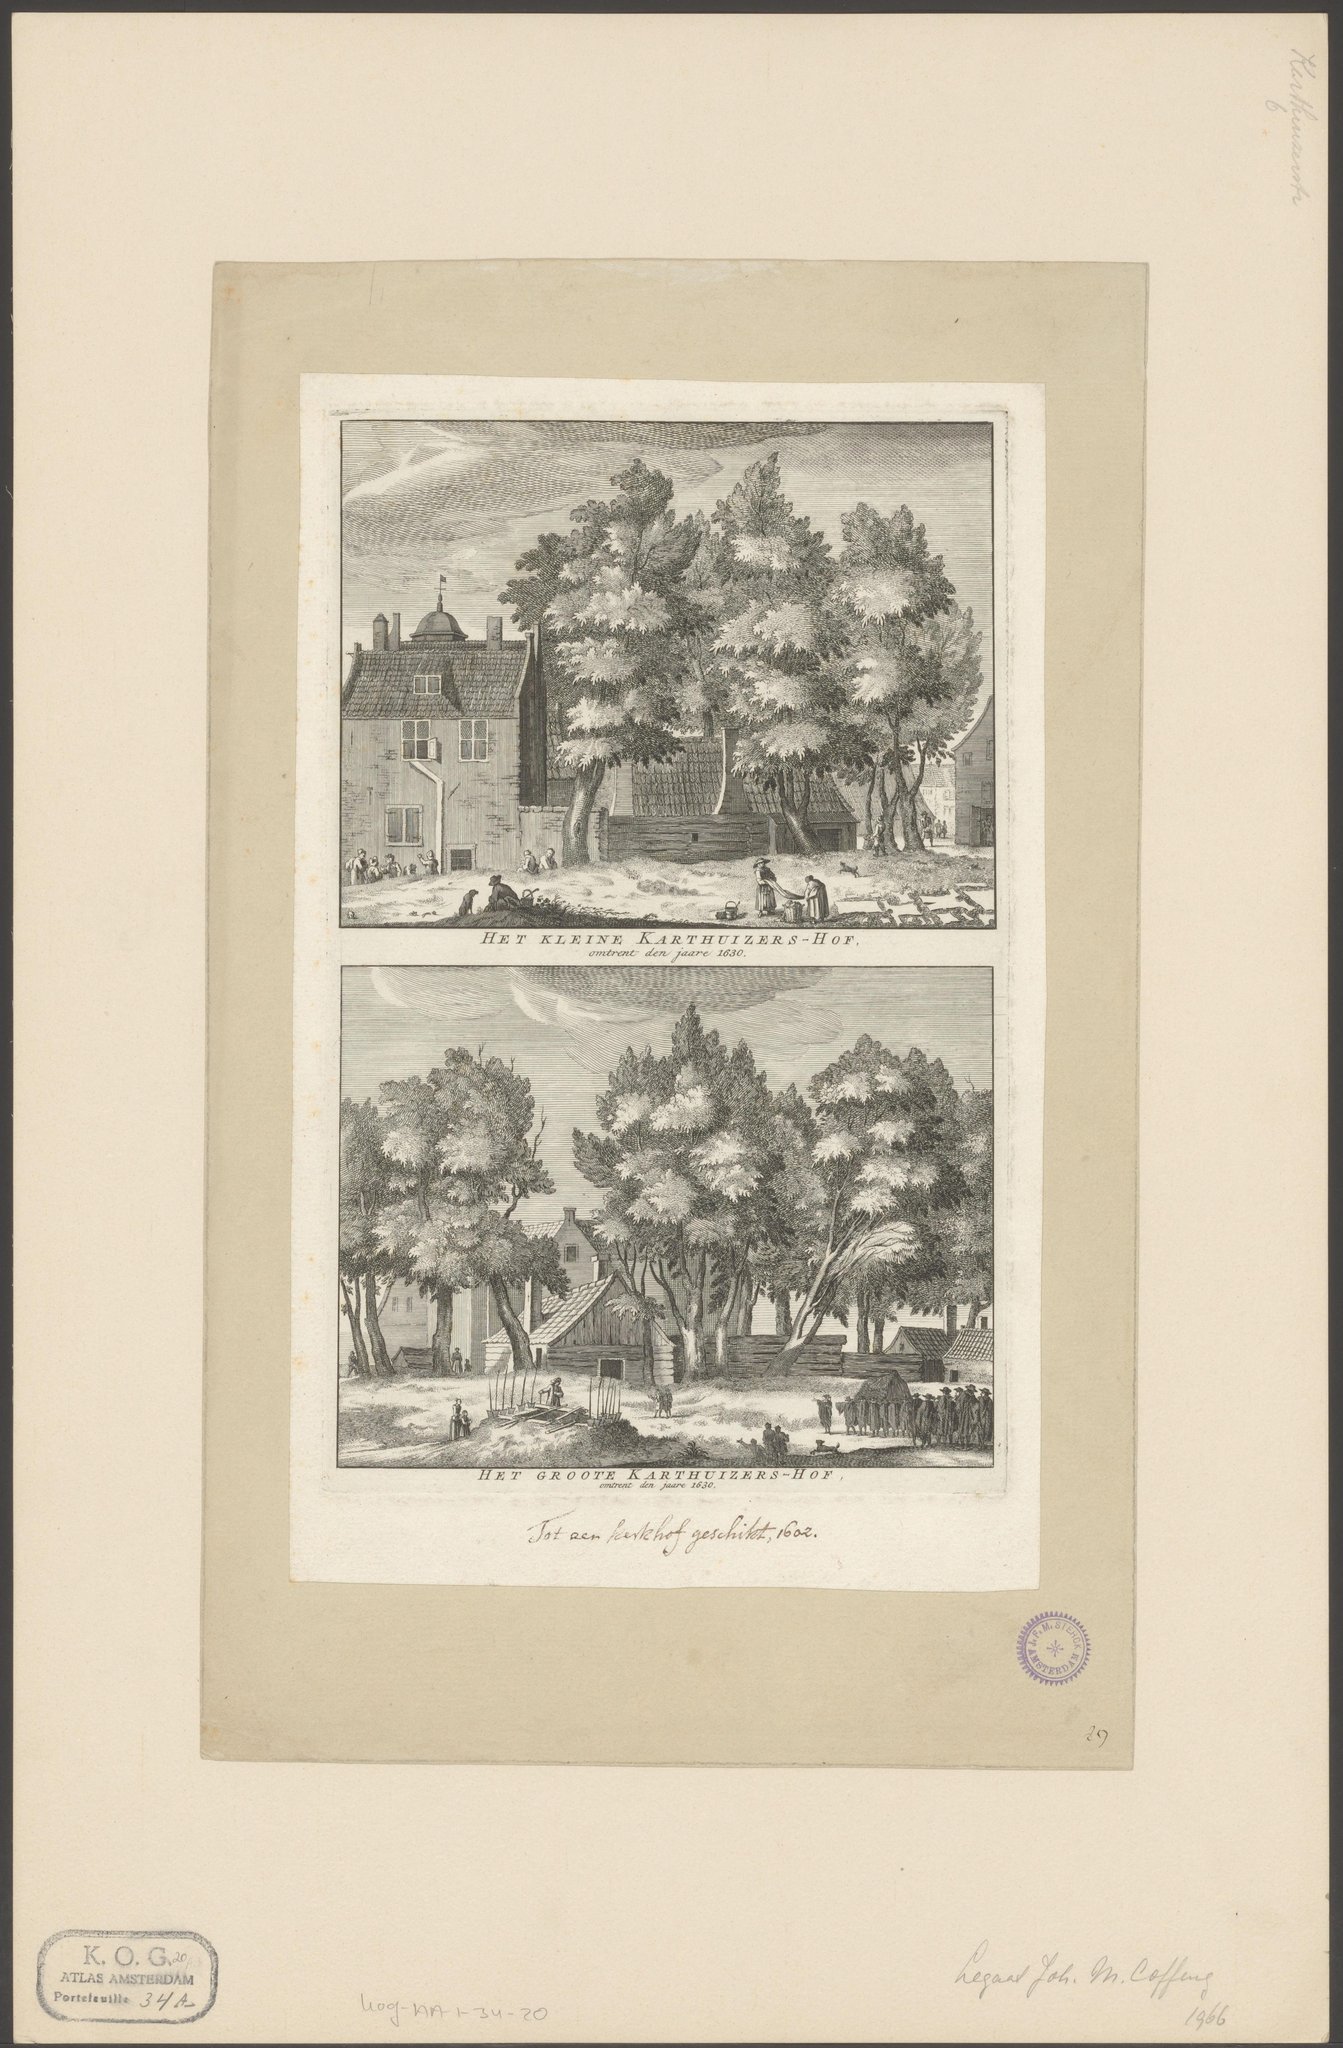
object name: print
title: Gezichten op het Kleine en Grote Karthuizerhof te Amsterdam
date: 1765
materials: paper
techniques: engraving, etching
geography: amsterdam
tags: alms-house (dutch: 'hofje'), trees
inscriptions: collector's mark: Lugt 1641b, collector's mark: ‘ J.F.M. STERCK AMSTERDAM ’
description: Prent mogelijk uit: Wagenaar, Jan. Amsterdam, in zyne opkomst, aanwas, geschiedenissen (…). Amsterdam: Isaak Tirion, 1765, dl. 2.